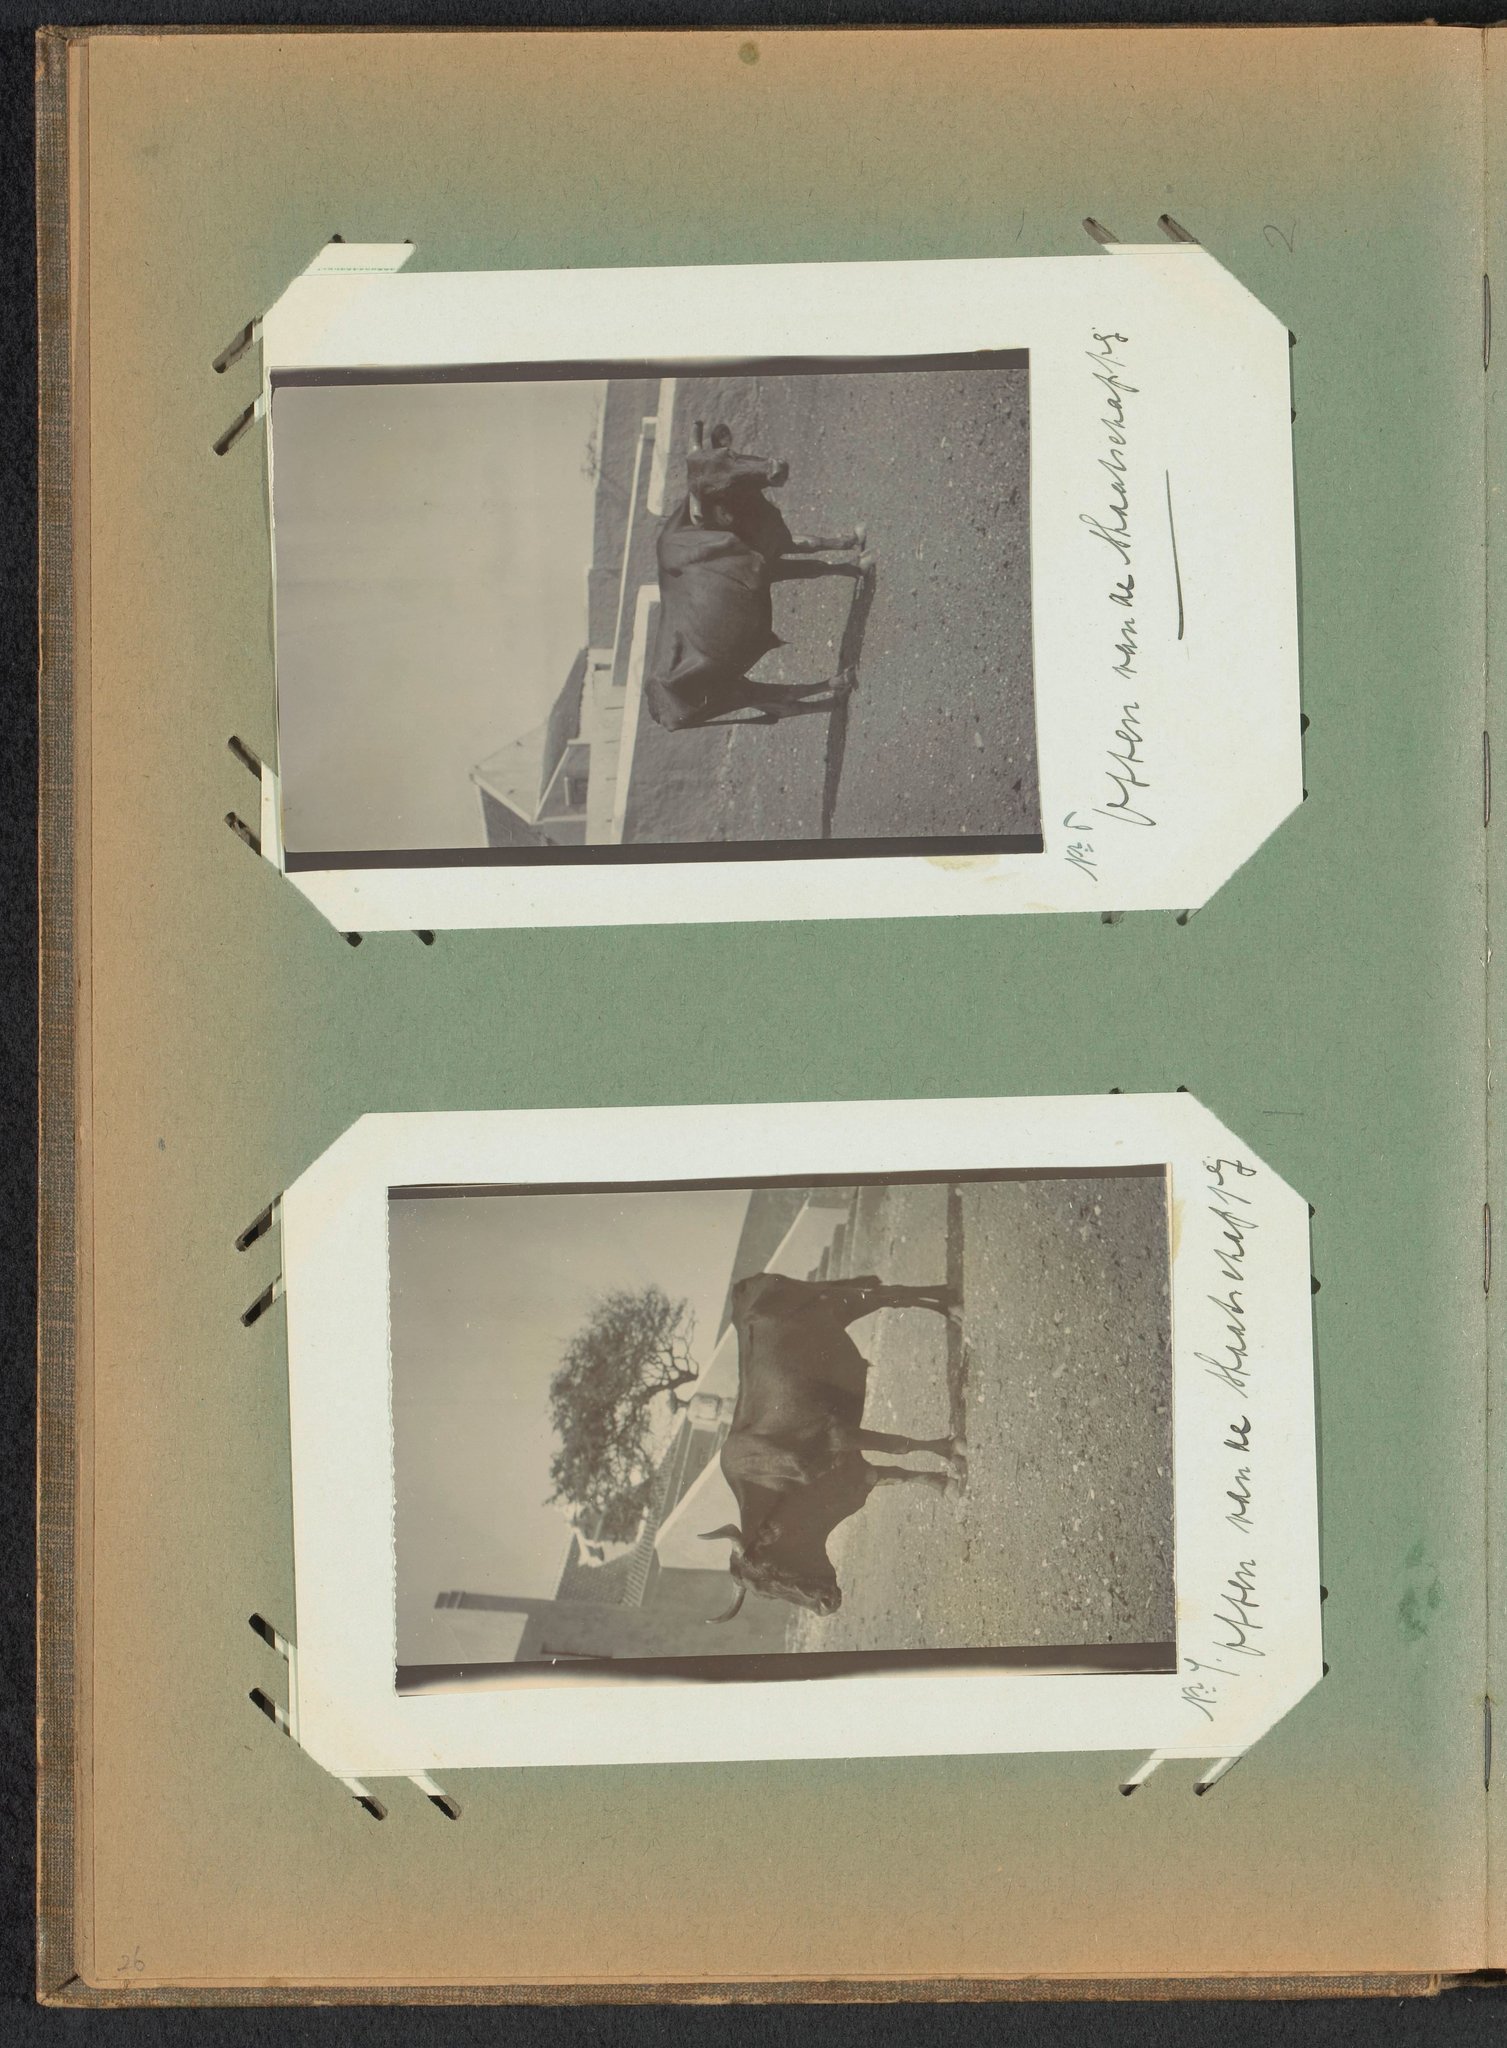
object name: photograph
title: Nr. 8 Ossen van de Maatschappij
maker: Anonymous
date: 1912-1913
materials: paper, photographic support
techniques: gelatin silver print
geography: curacao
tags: plantation, ox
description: Os van de plantage Mount Pleasant op Curaçao. Onderdeel van het fotoalbum uit ca. 1912-1913 met 92 foto's van de plantages Peperpot en Dordrecht in Suriname en Mount Pleasant op Curaçao.